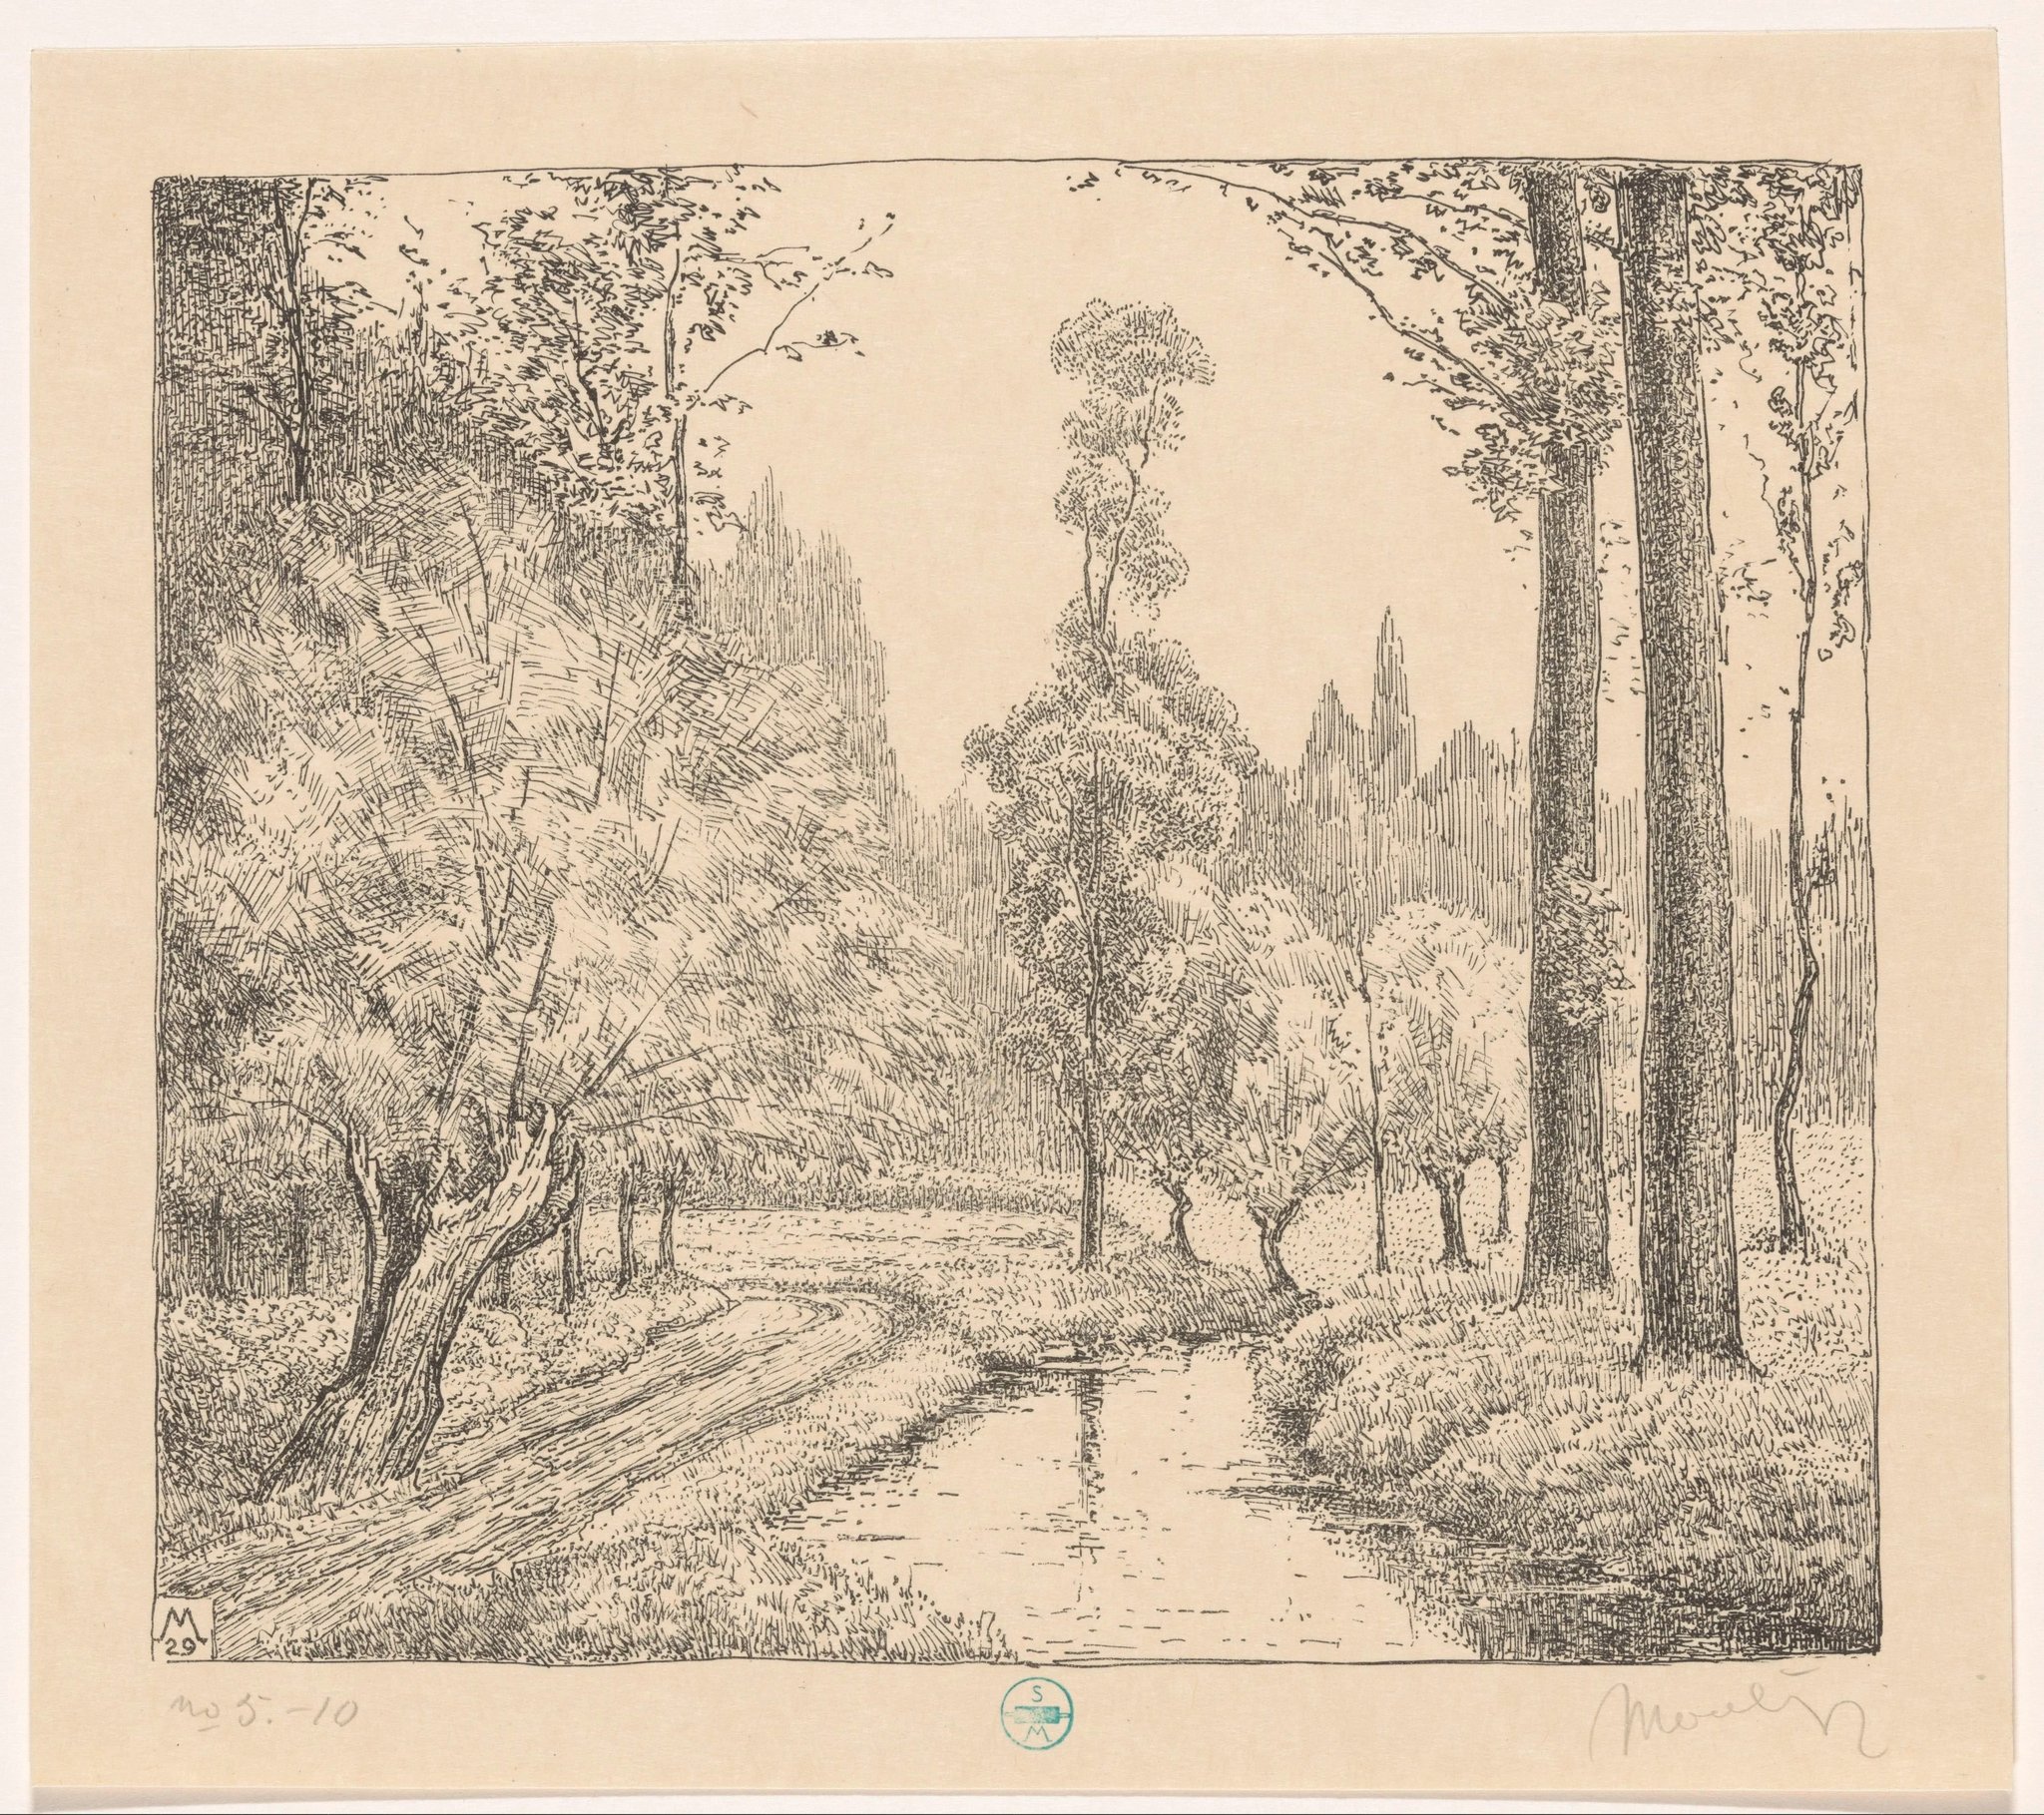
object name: print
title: Park met water en bomen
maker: simon moulijn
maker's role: draughtsman, print maker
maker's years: 1866-1948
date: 1929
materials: paper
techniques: lithograph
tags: park, river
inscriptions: collector's mark: Lugt 2228, stamp: Lugt 2362b